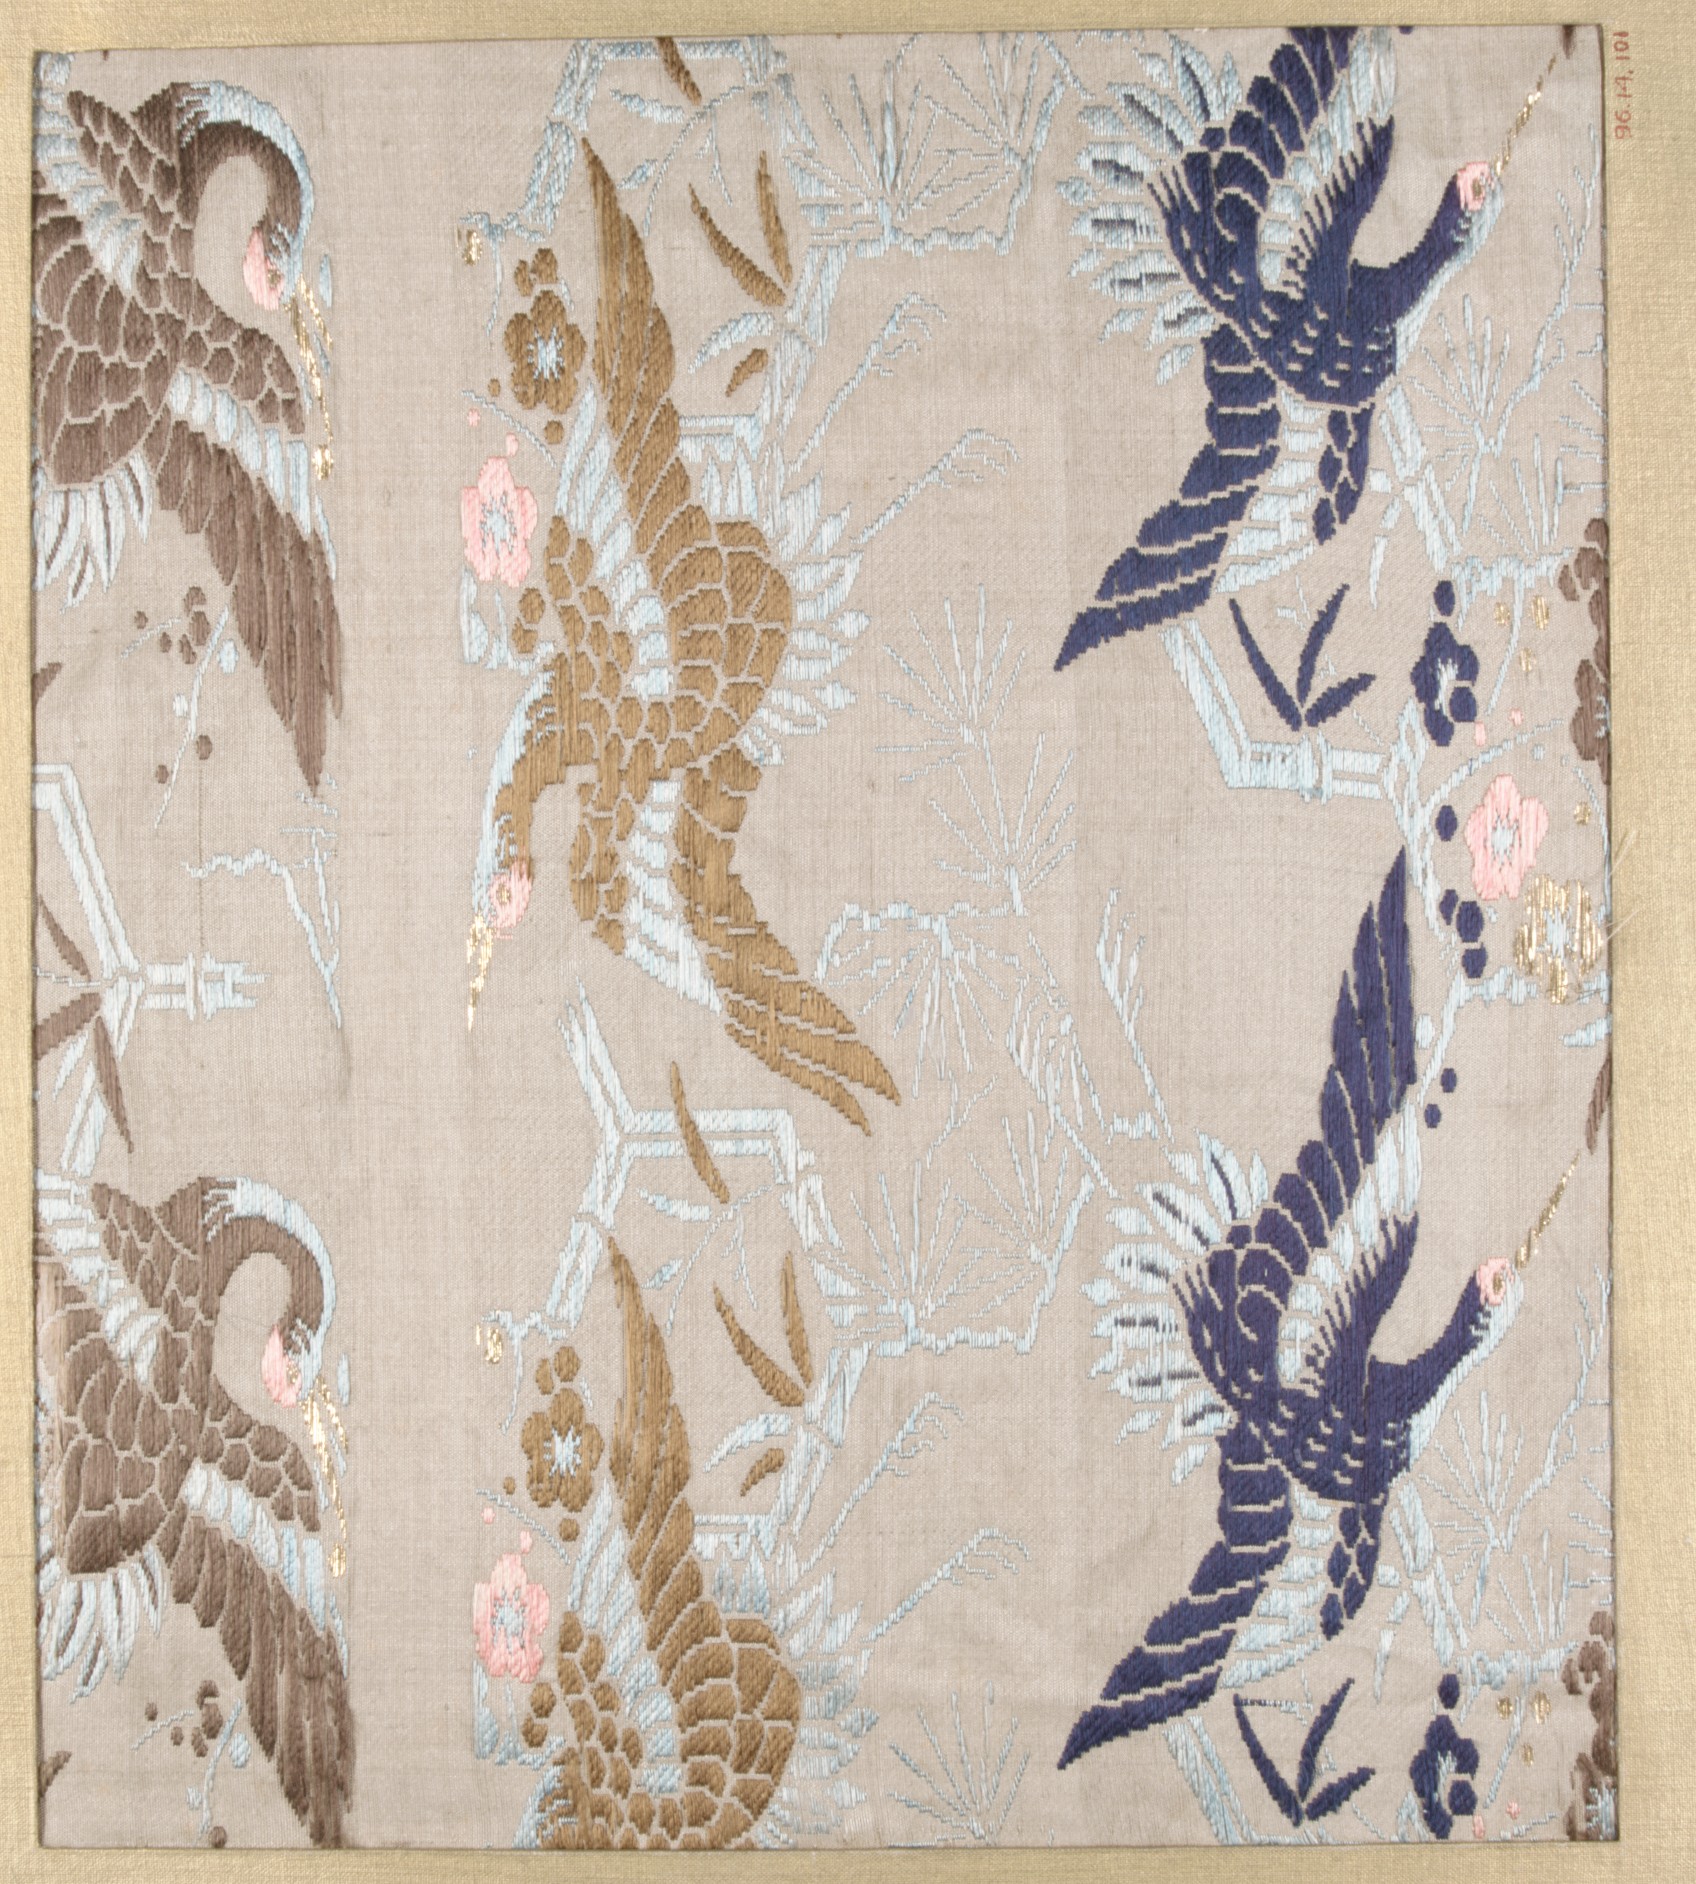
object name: piece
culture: japanese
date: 1701-1900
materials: silk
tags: cranes